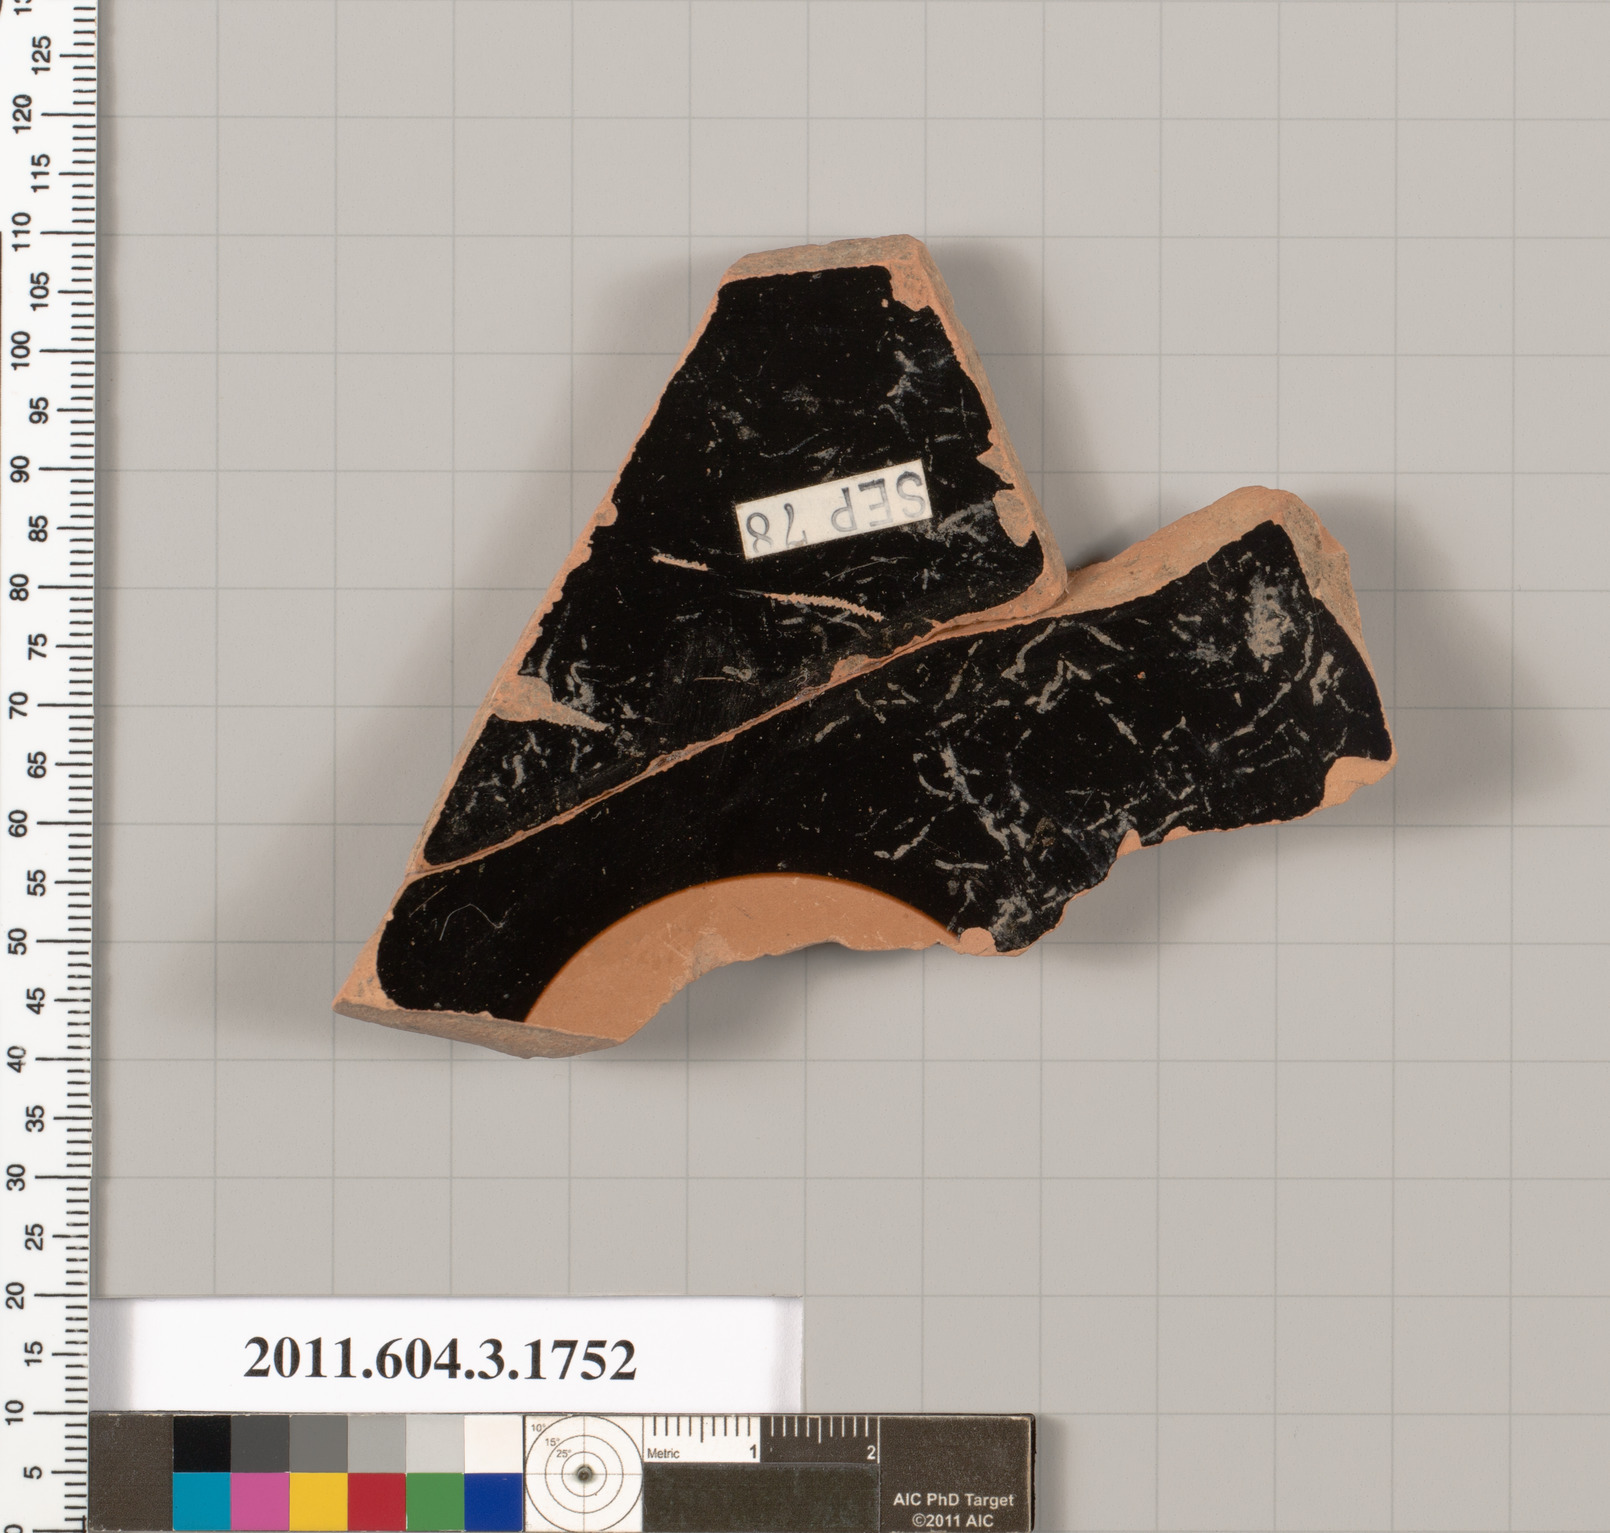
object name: kylix fragment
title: Terracotta fragment of a kylix: Band or lip cup (drinking cup)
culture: greek, attic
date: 550-526 BCE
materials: terracotta